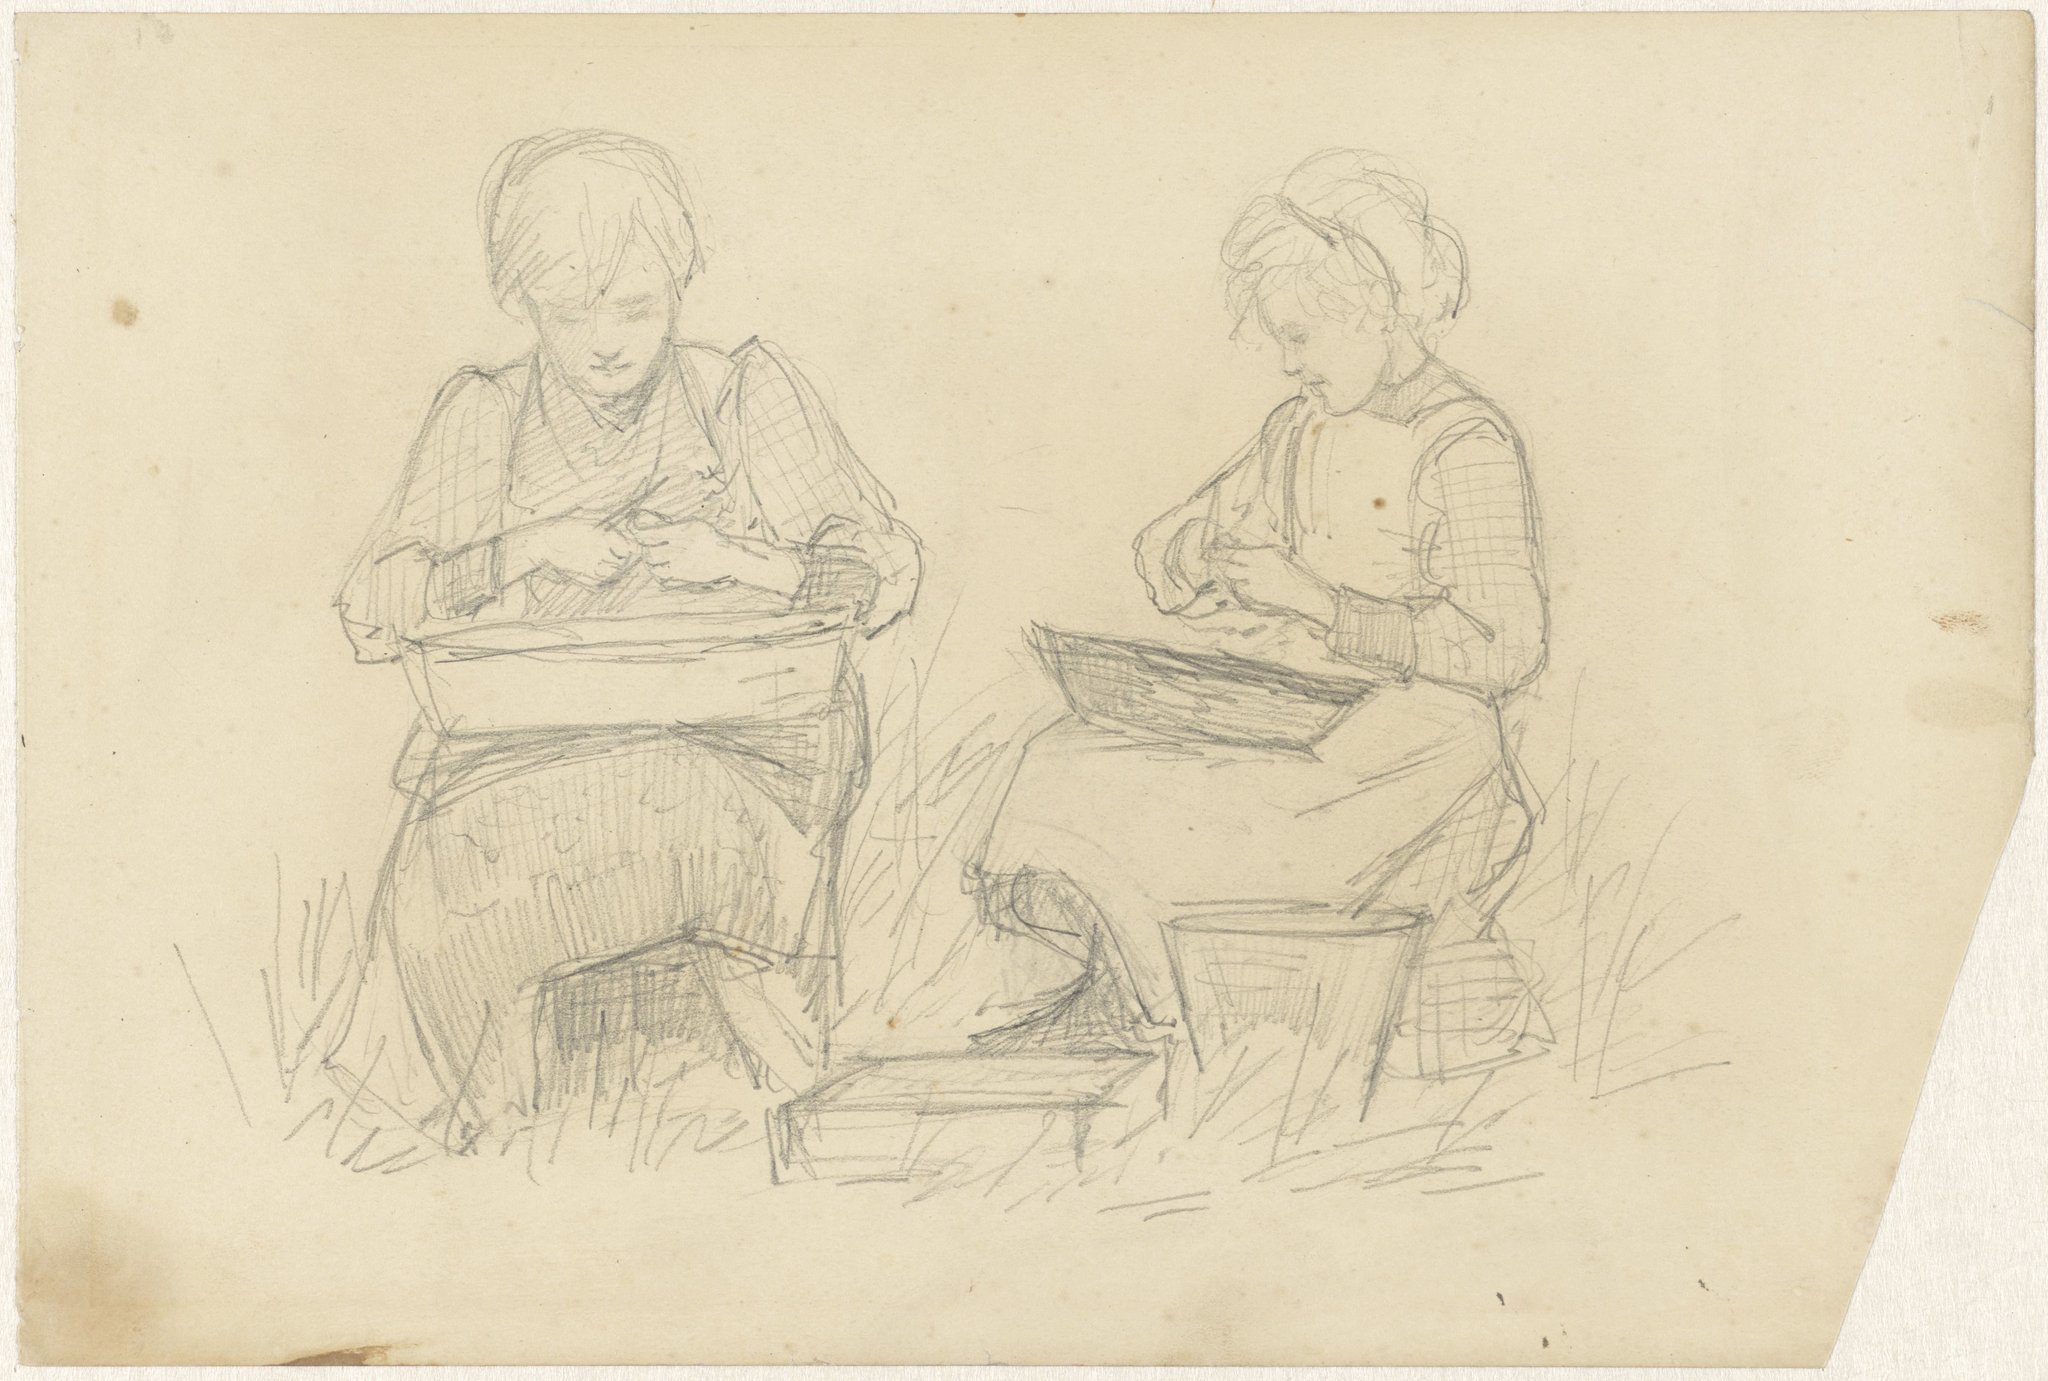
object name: drawing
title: Twee zittende, schillende vrouwen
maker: jozef israëls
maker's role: draughtsman, painter, print maker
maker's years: 1824-1911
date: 1834-1911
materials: paper, pencil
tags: potatoes, cleaning vegetables